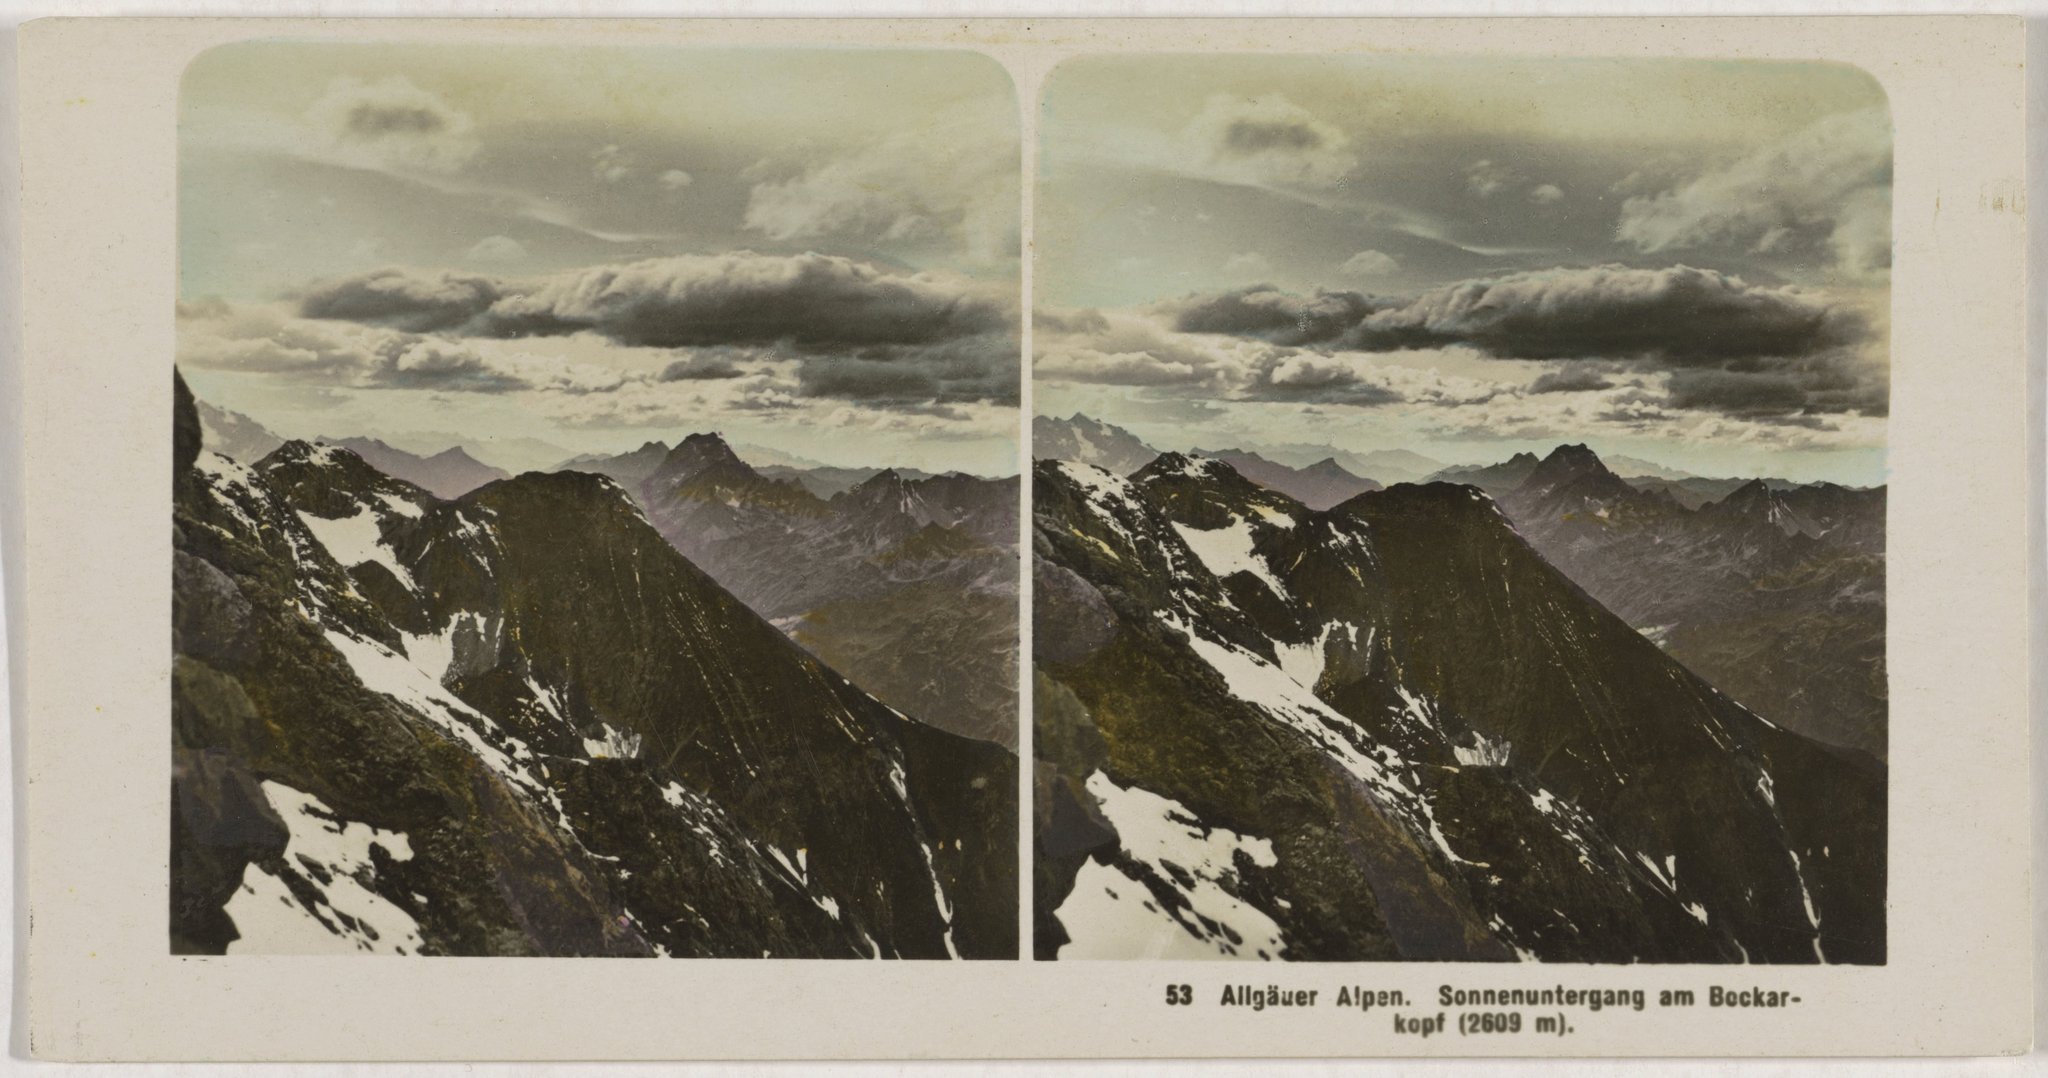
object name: stereograph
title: Bockar-Kopf in de Allgäuer Alpen, Duitsland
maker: bw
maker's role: fotograaf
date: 1898-1935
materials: photographic support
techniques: gelatin silver print, hand coloring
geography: allgäuer alpen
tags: mountain-range, snow peaks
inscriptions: number: ‘53’, inscription: ‘Deutschland. Bayern. Allgäuer Alpen. Sonnenuntergan/ am Bockar-Kopf (2609 m). / Germany. Bavaria. Allgäu-Alps. Sunset at the "Bockarkopf" (2609 m). / Allemagne. Vacière. Les Alpes de l'Allgäu. Coucher du/ soleil au "Bockarkopf" (2609 m). / Alemania. Baviera. Los Alpes del/ Allgäu. Puesta del sol al "Bockarkopf" (2609 m).’, monogram: ‘BW’